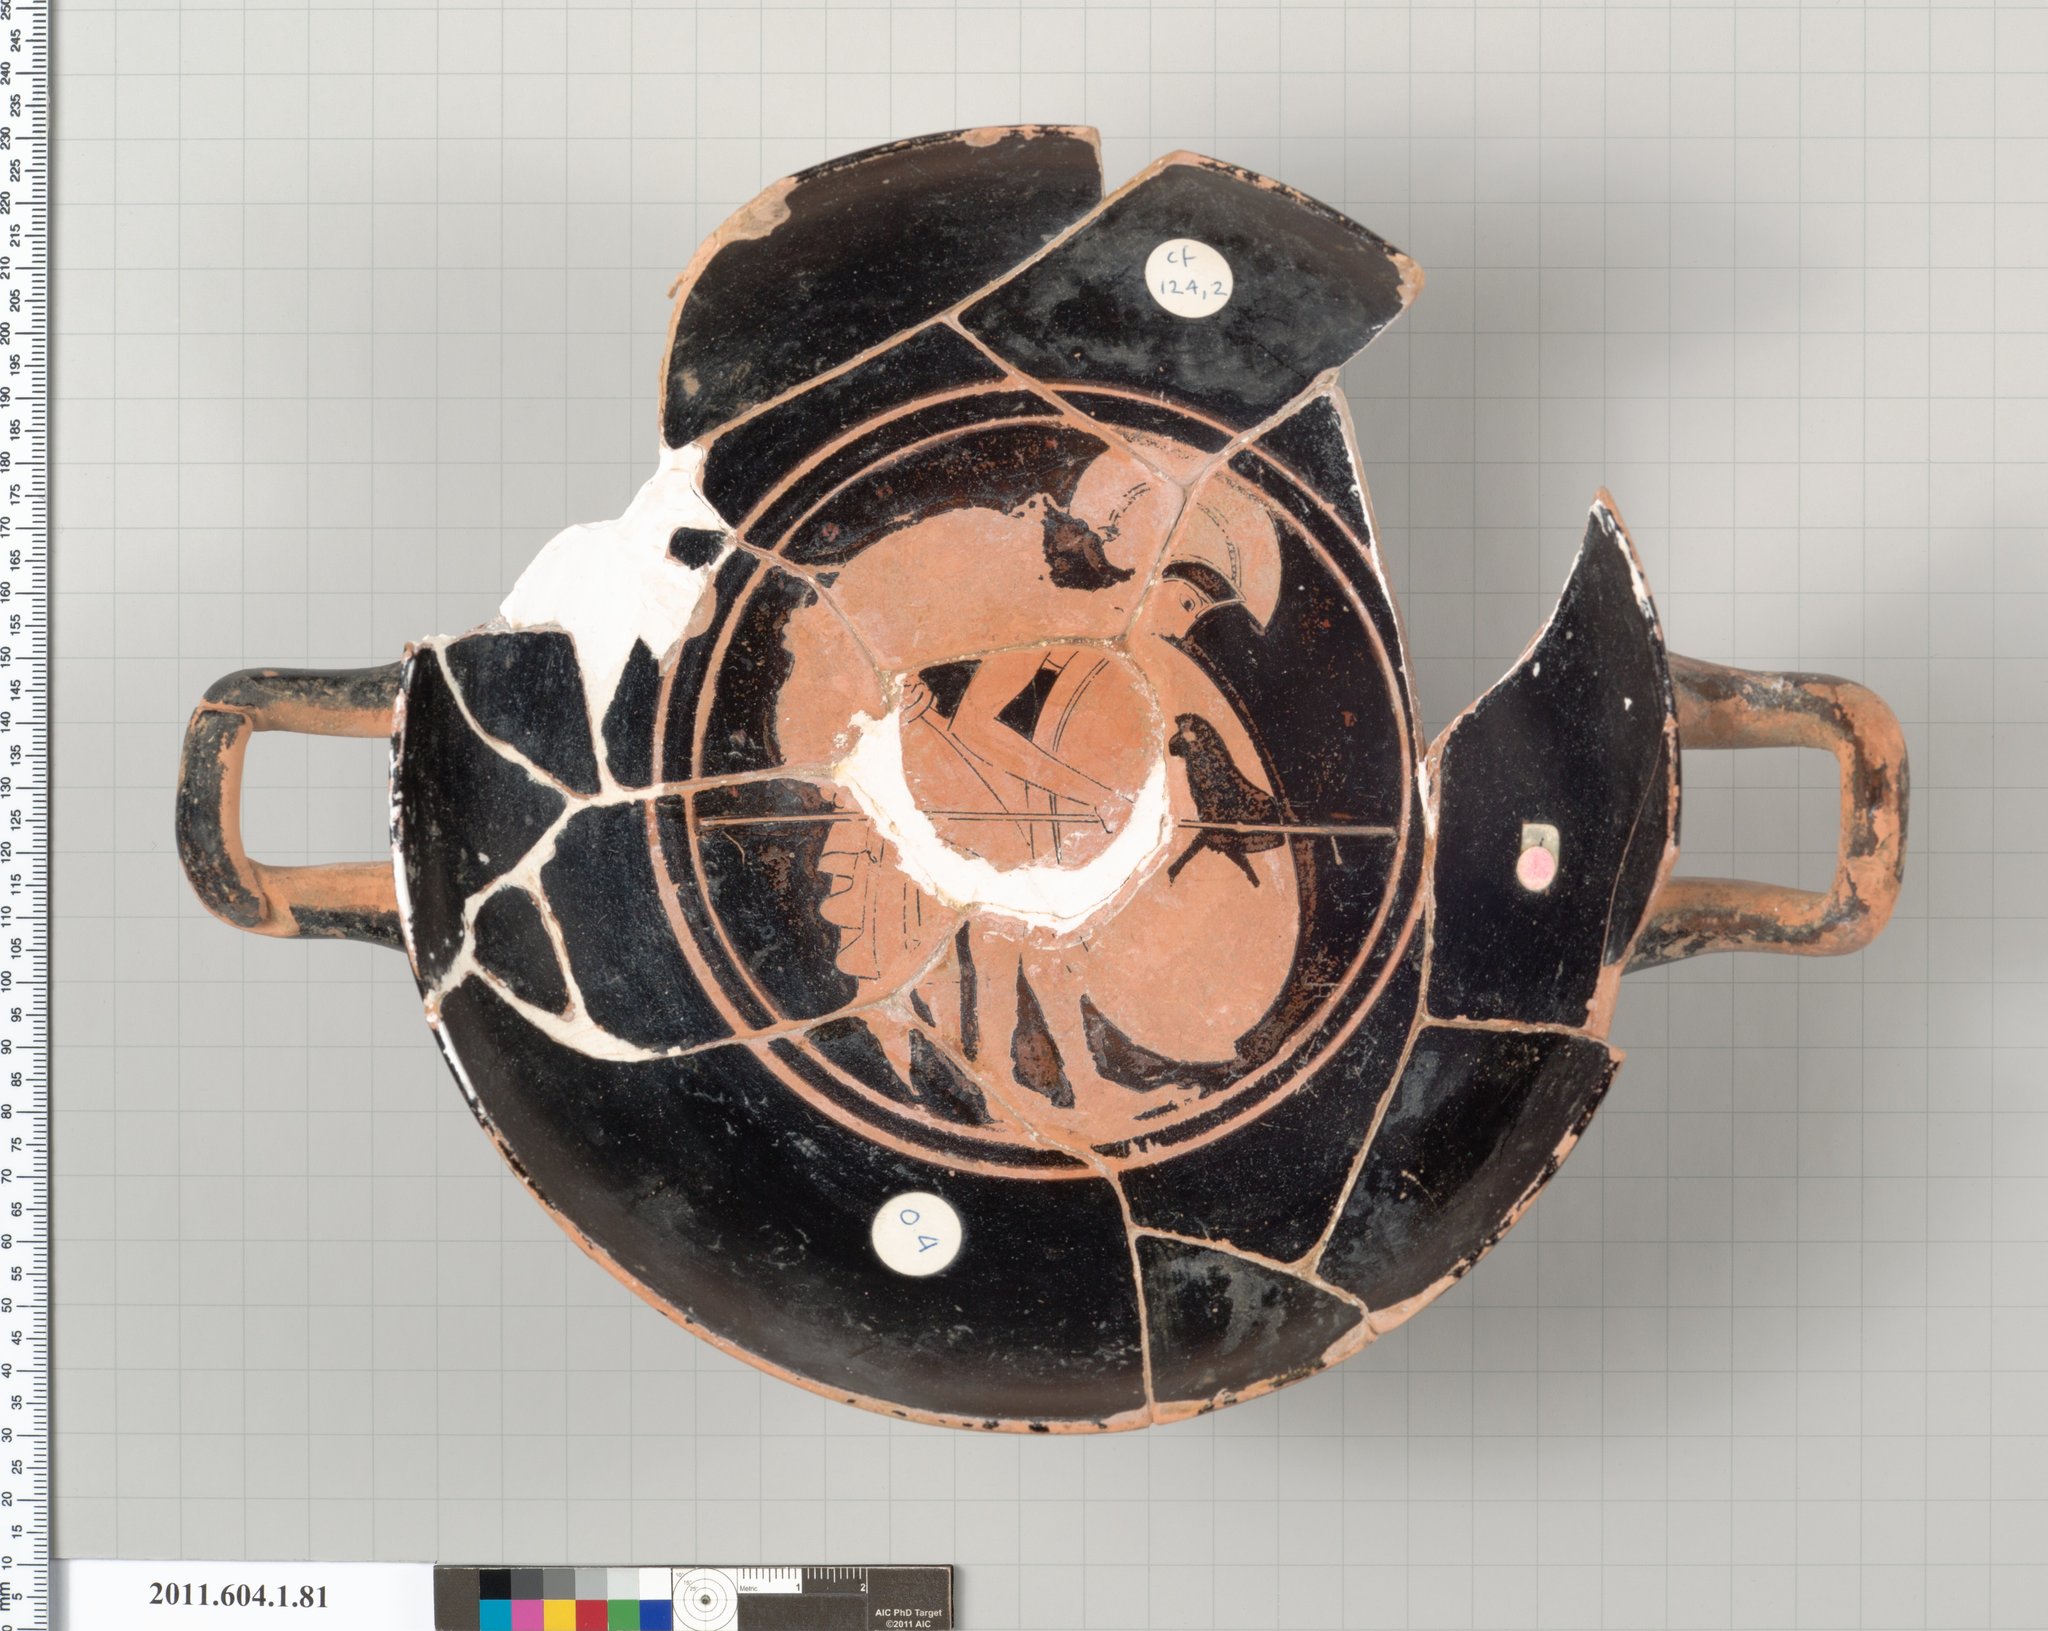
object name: kylix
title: Terracotta kylix (drinking cup)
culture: greek, attic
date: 510-500 BCE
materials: terracotta